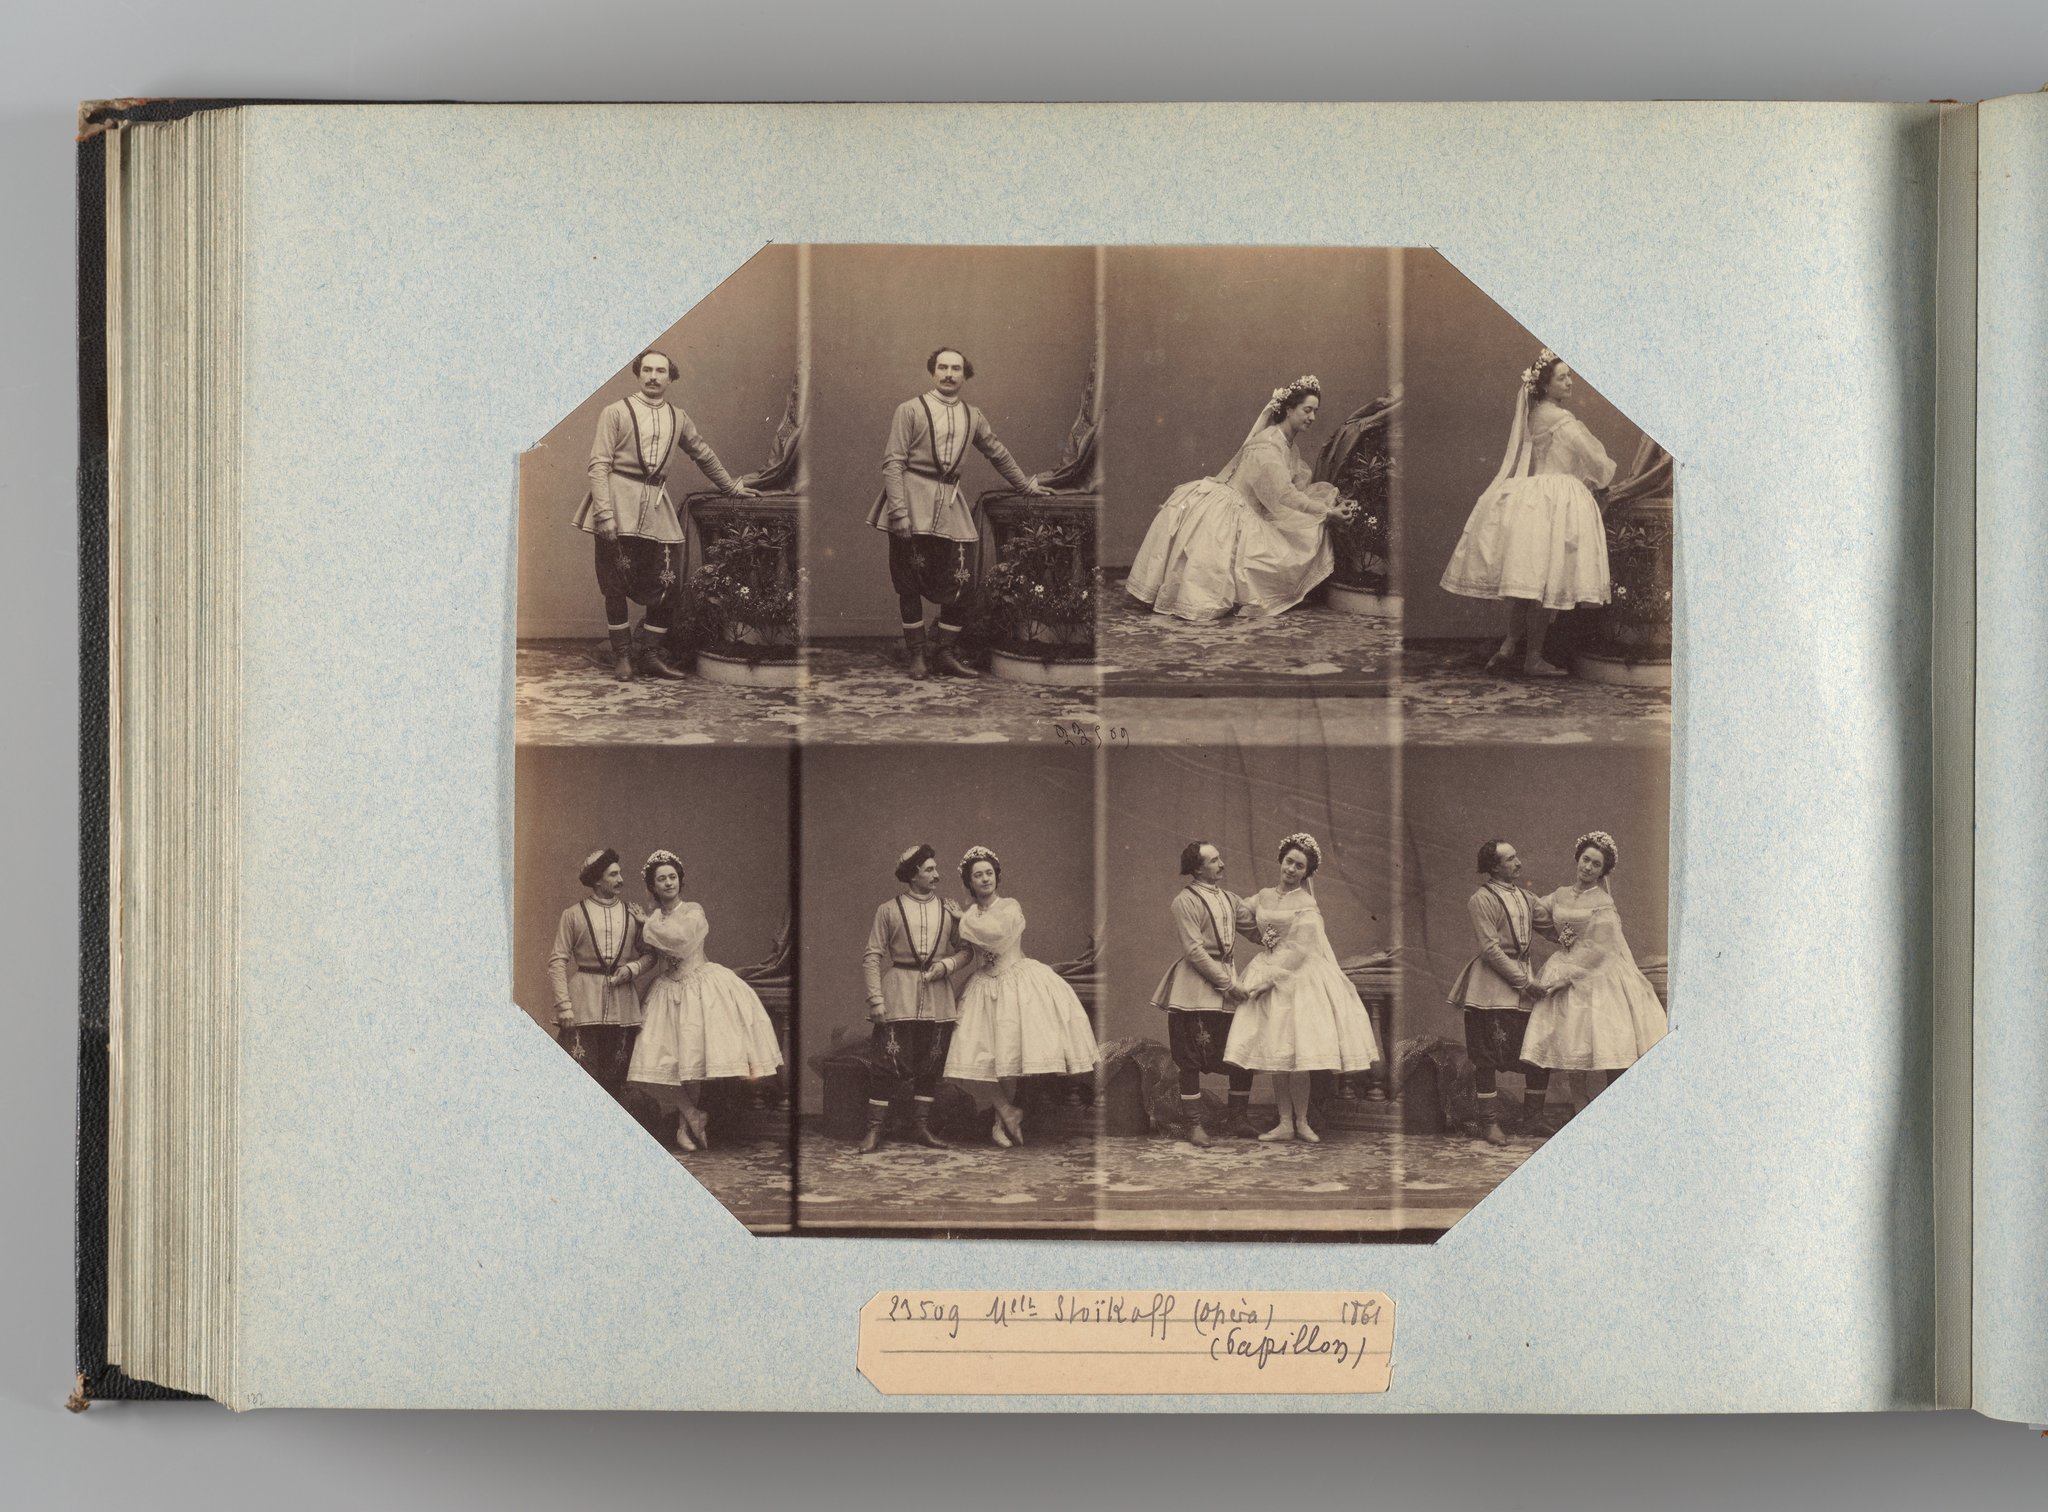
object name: photograph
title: Mlle Stoïkoff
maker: andré-adolphe-eugène disdéri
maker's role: artist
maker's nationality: french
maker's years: 1819-1889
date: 1861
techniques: albumen silver print, glass negative